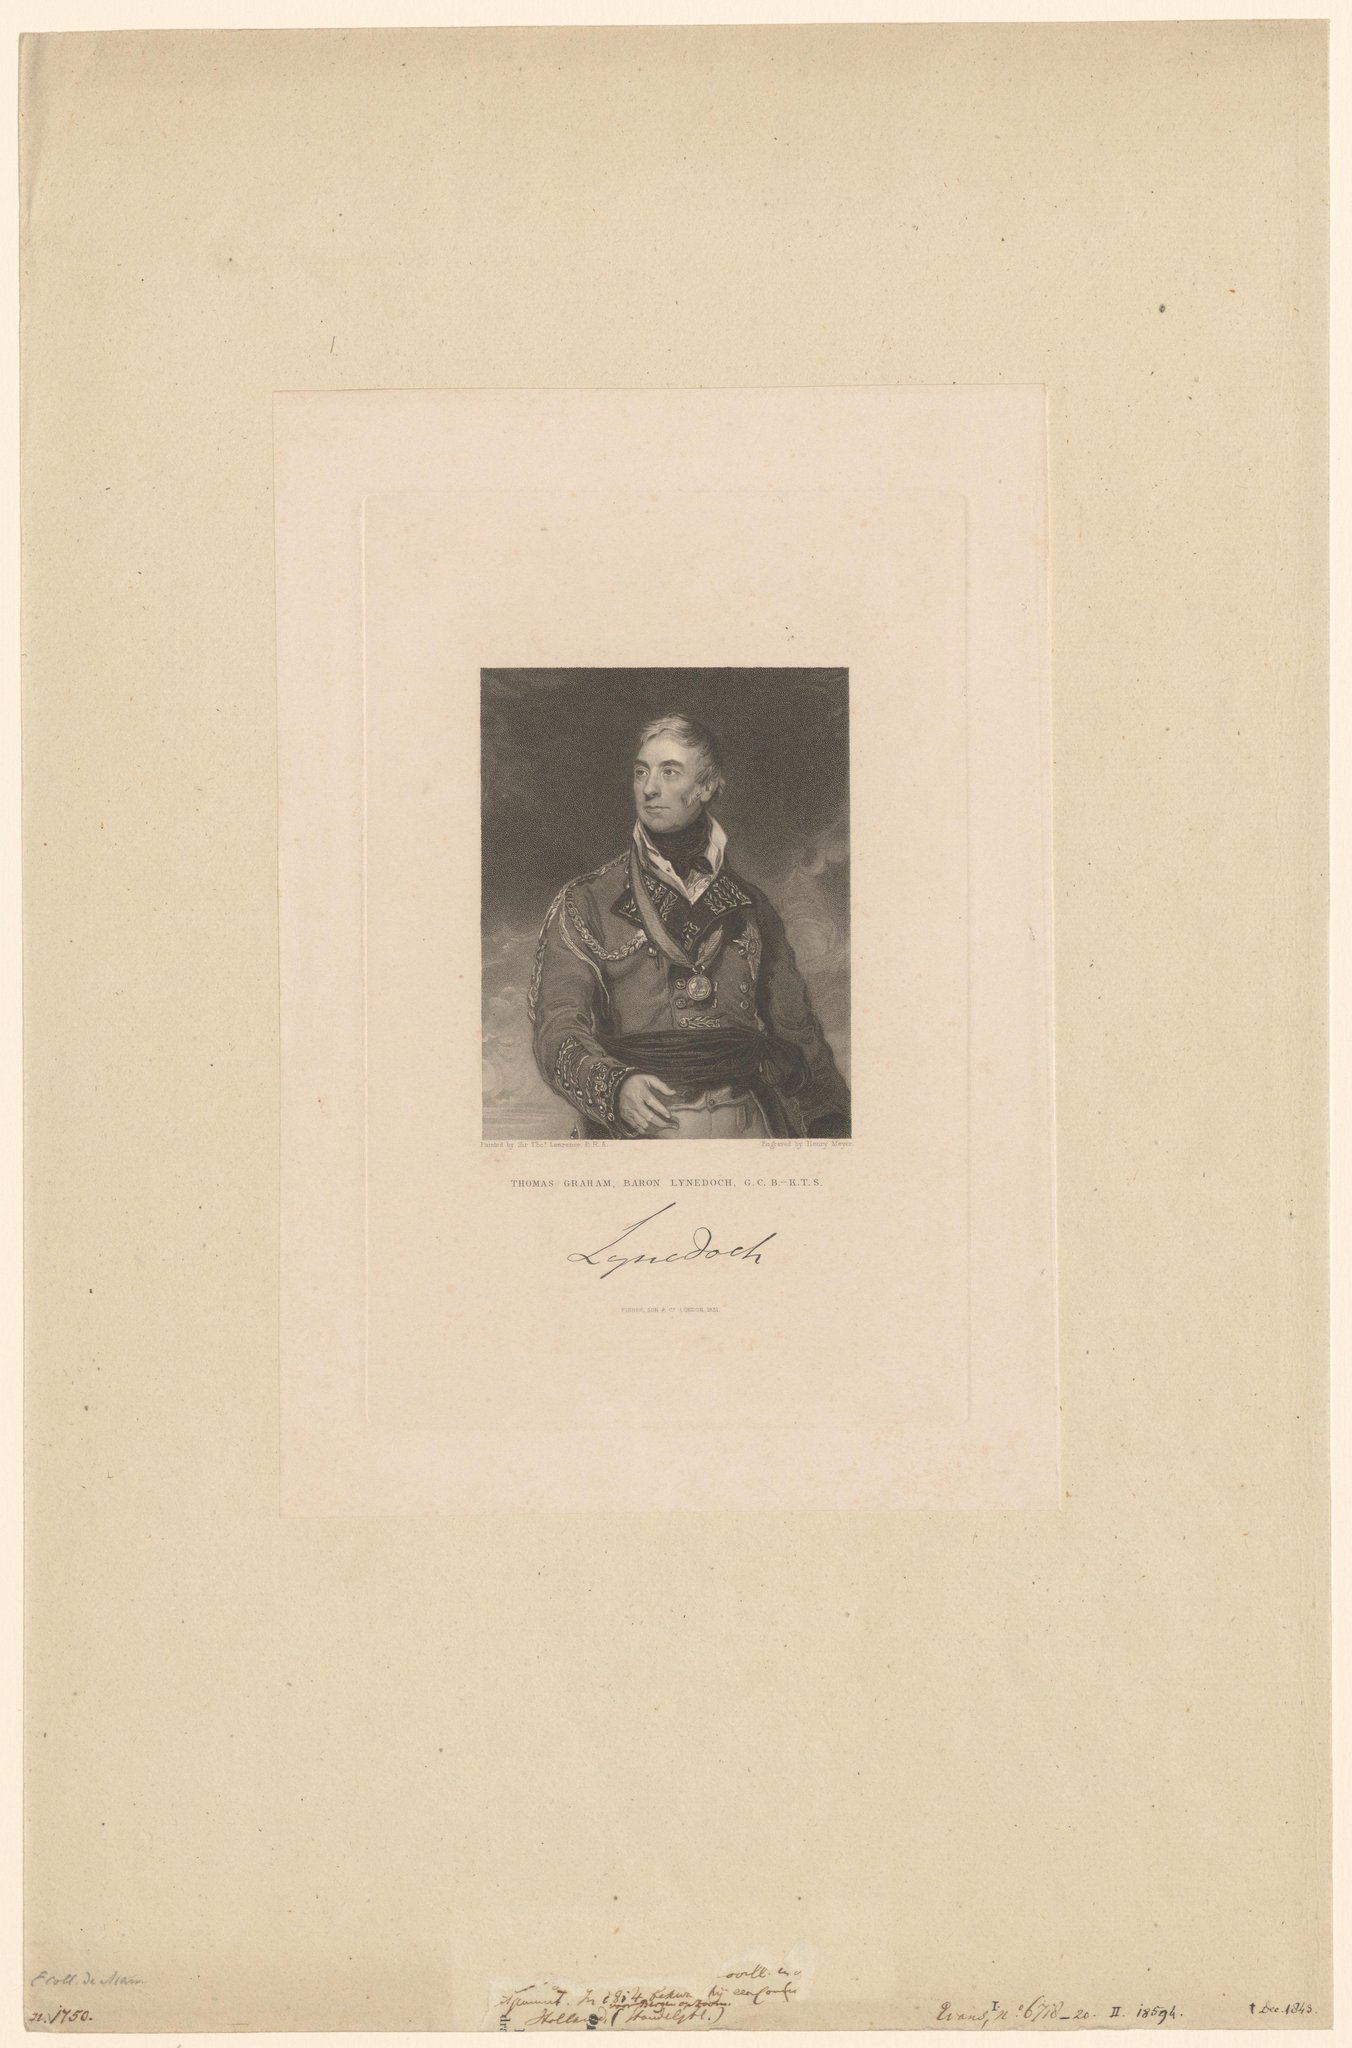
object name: book illustration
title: Thomas Graham, Baron Lynedoch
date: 1831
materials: paper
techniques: engraving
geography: london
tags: historical persons, politician, e.g. party leader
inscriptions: collector's mark: Lugt 2228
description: Prent uit: Jerdan, William. National Portrait Gallery of Illustrious and Eminent Persons of the 19th Century. Londen: Fisher, Son & Co., 1831.